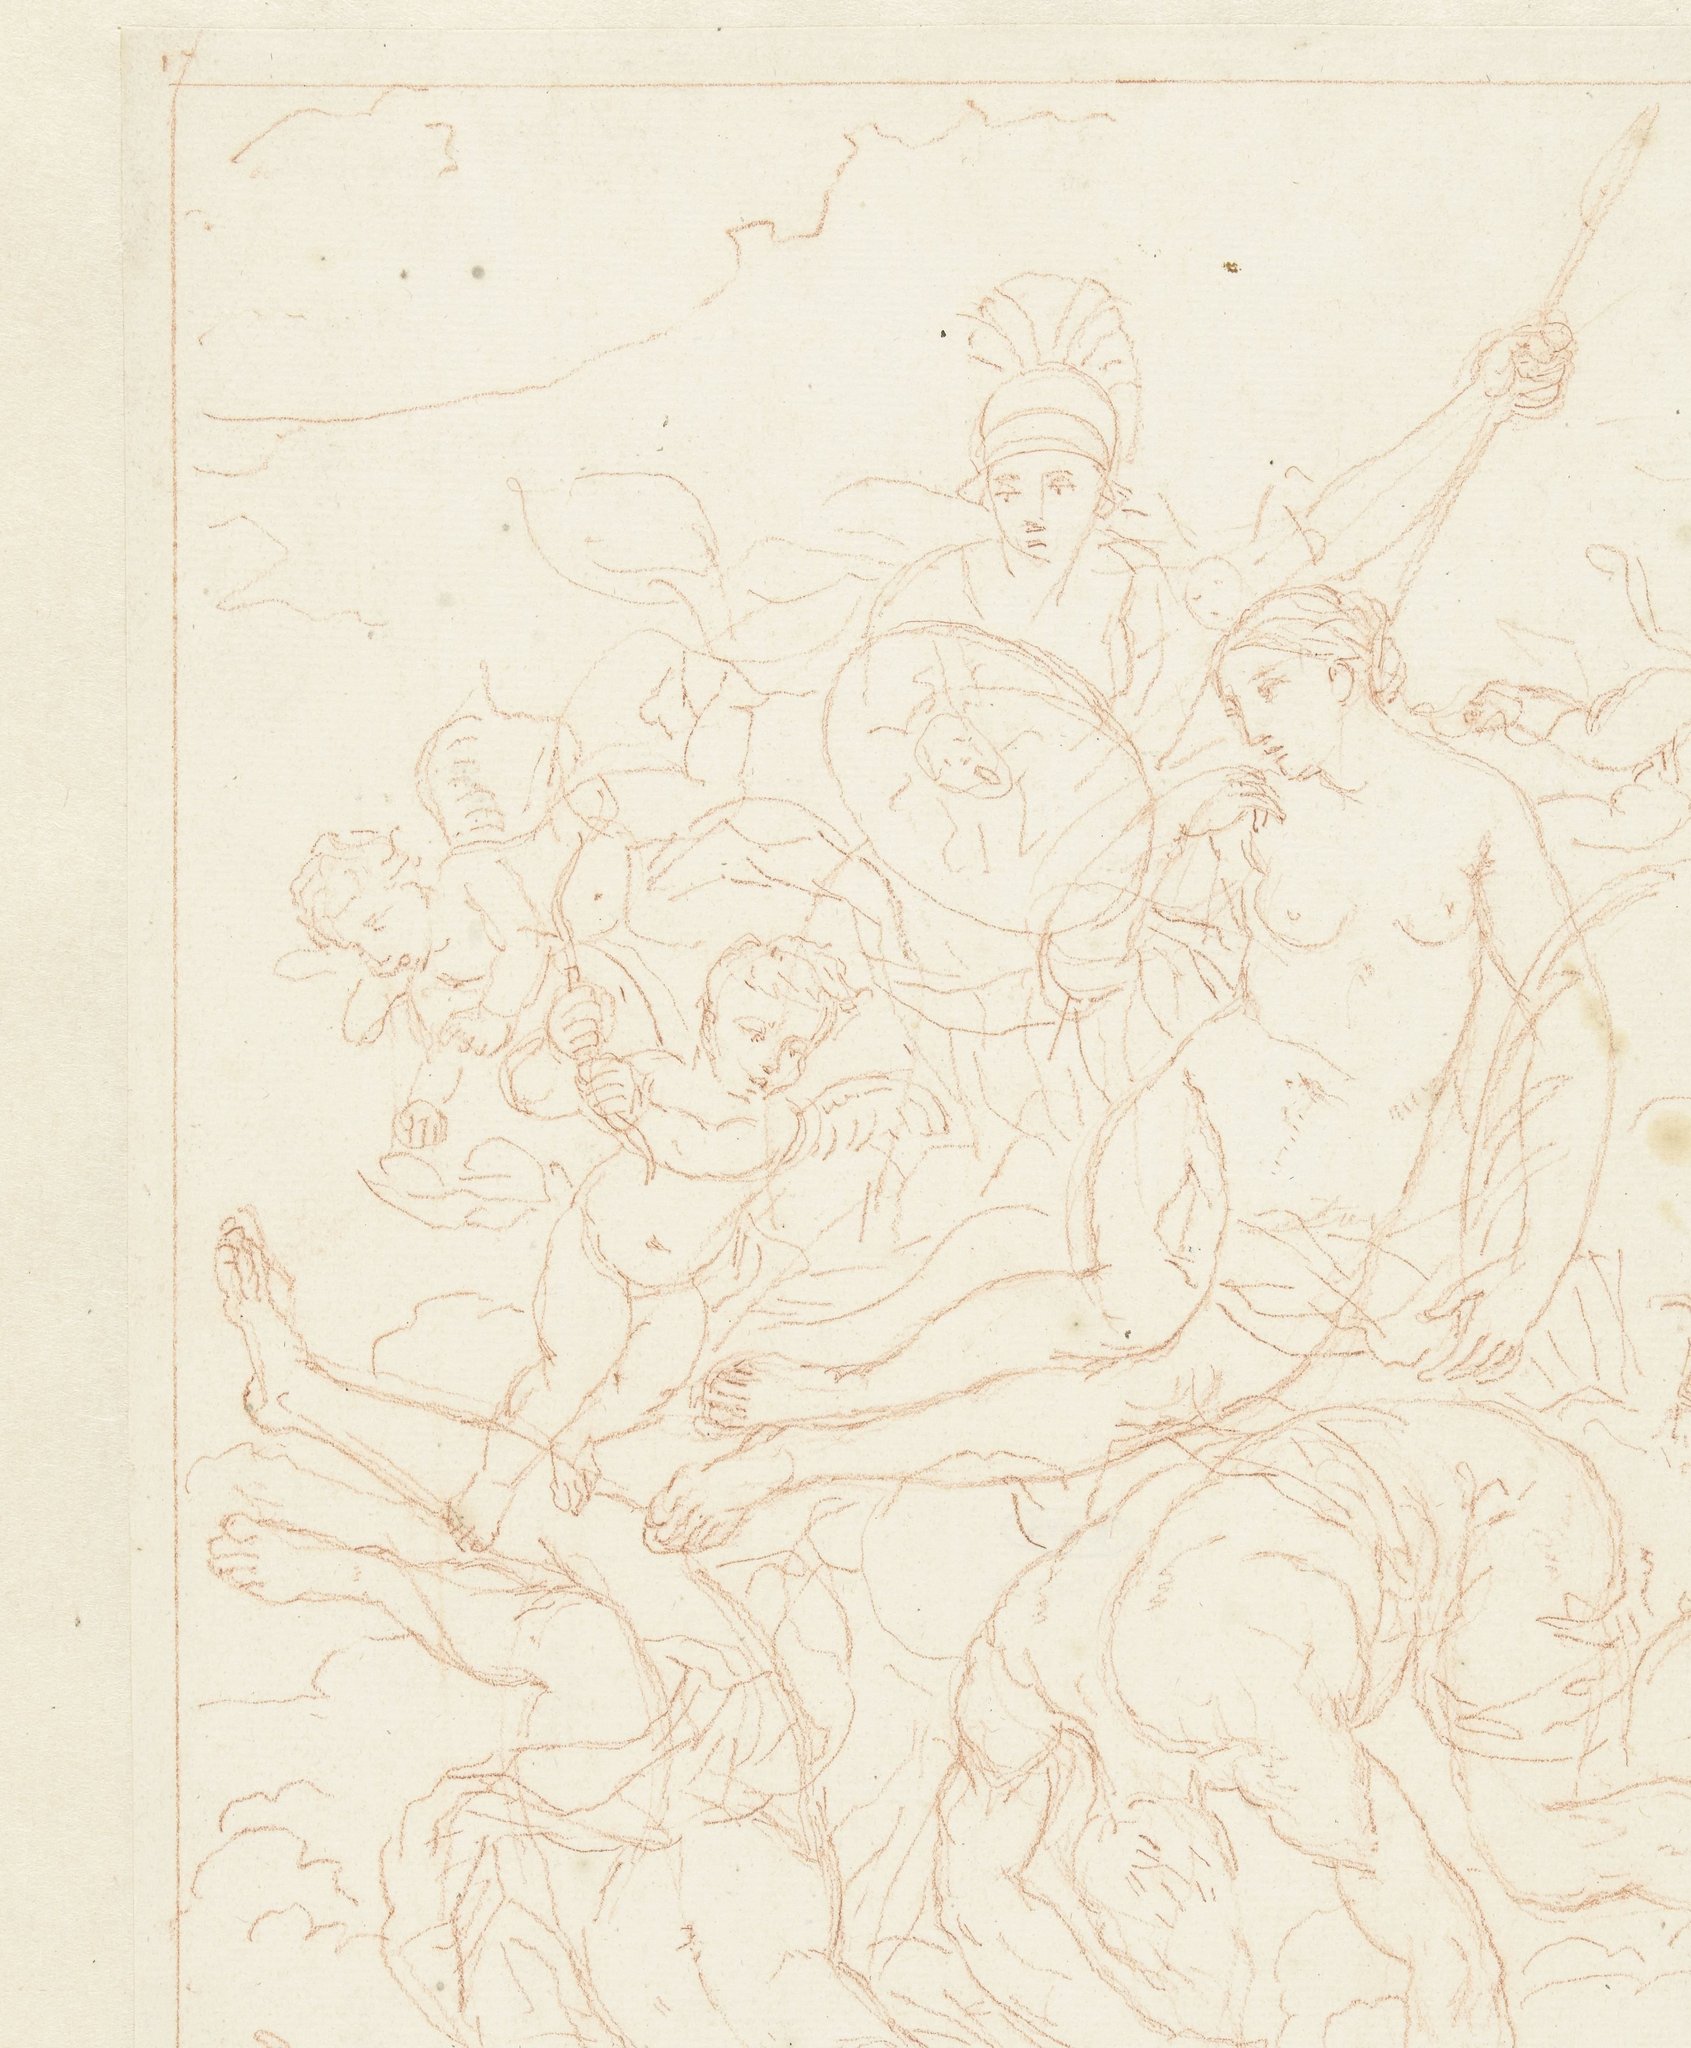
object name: drawing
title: Allegorie met een personificatie en Minerva die de Nijd en Bedrog overwinnen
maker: louis fabritius dubourg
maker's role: draughtsman, print maker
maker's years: 1693-1775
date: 1703-1775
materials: chalk, paper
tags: (story of) minerva (pallas, athena)